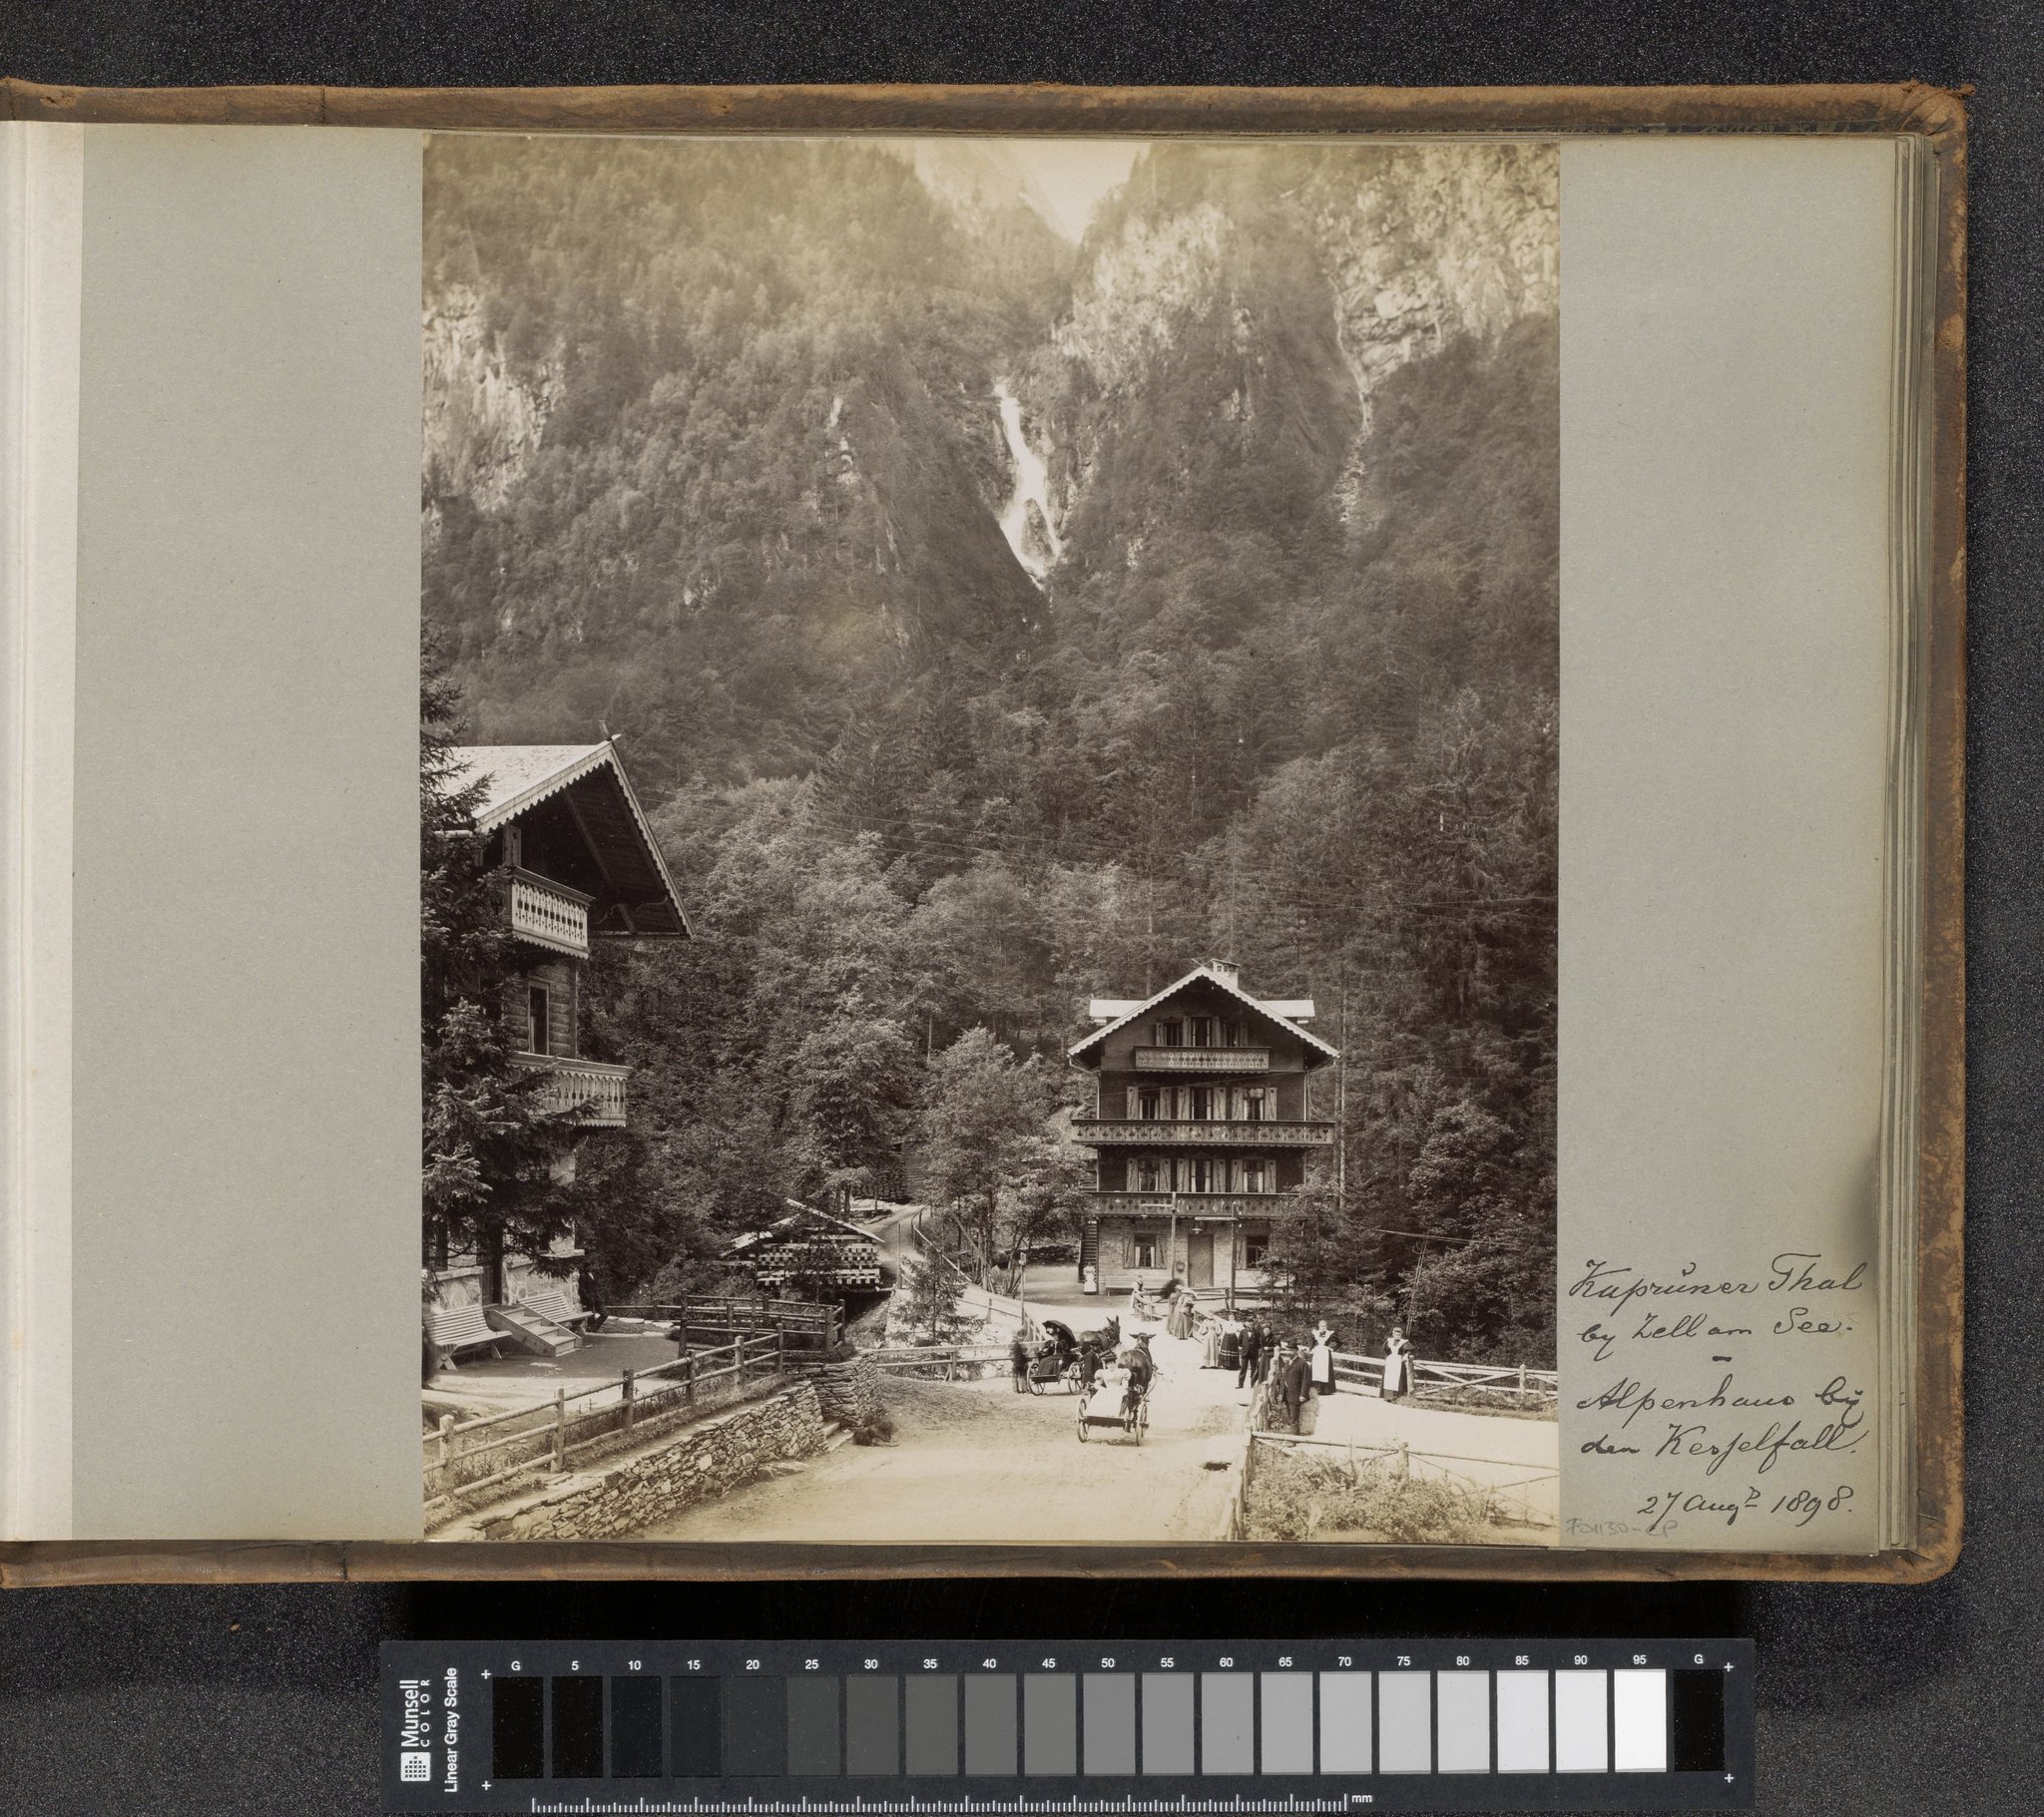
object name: album leaf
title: Dorpsgezicht in het Kapruner Tal met vrouwen in rijtuigen en op de achtergrond de Kesselfall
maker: Anonymous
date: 1880-1898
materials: paper, photographic support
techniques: albumen print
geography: salzburg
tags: two-wheeled, animal-drawn vehicle, waterfall, village street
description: Onderdeel van Reisalbum met foto's van bezienswaardigheden in Frankrijk, Spanje, Italië, Duitsland, Zwitserland en Oostenrijk.